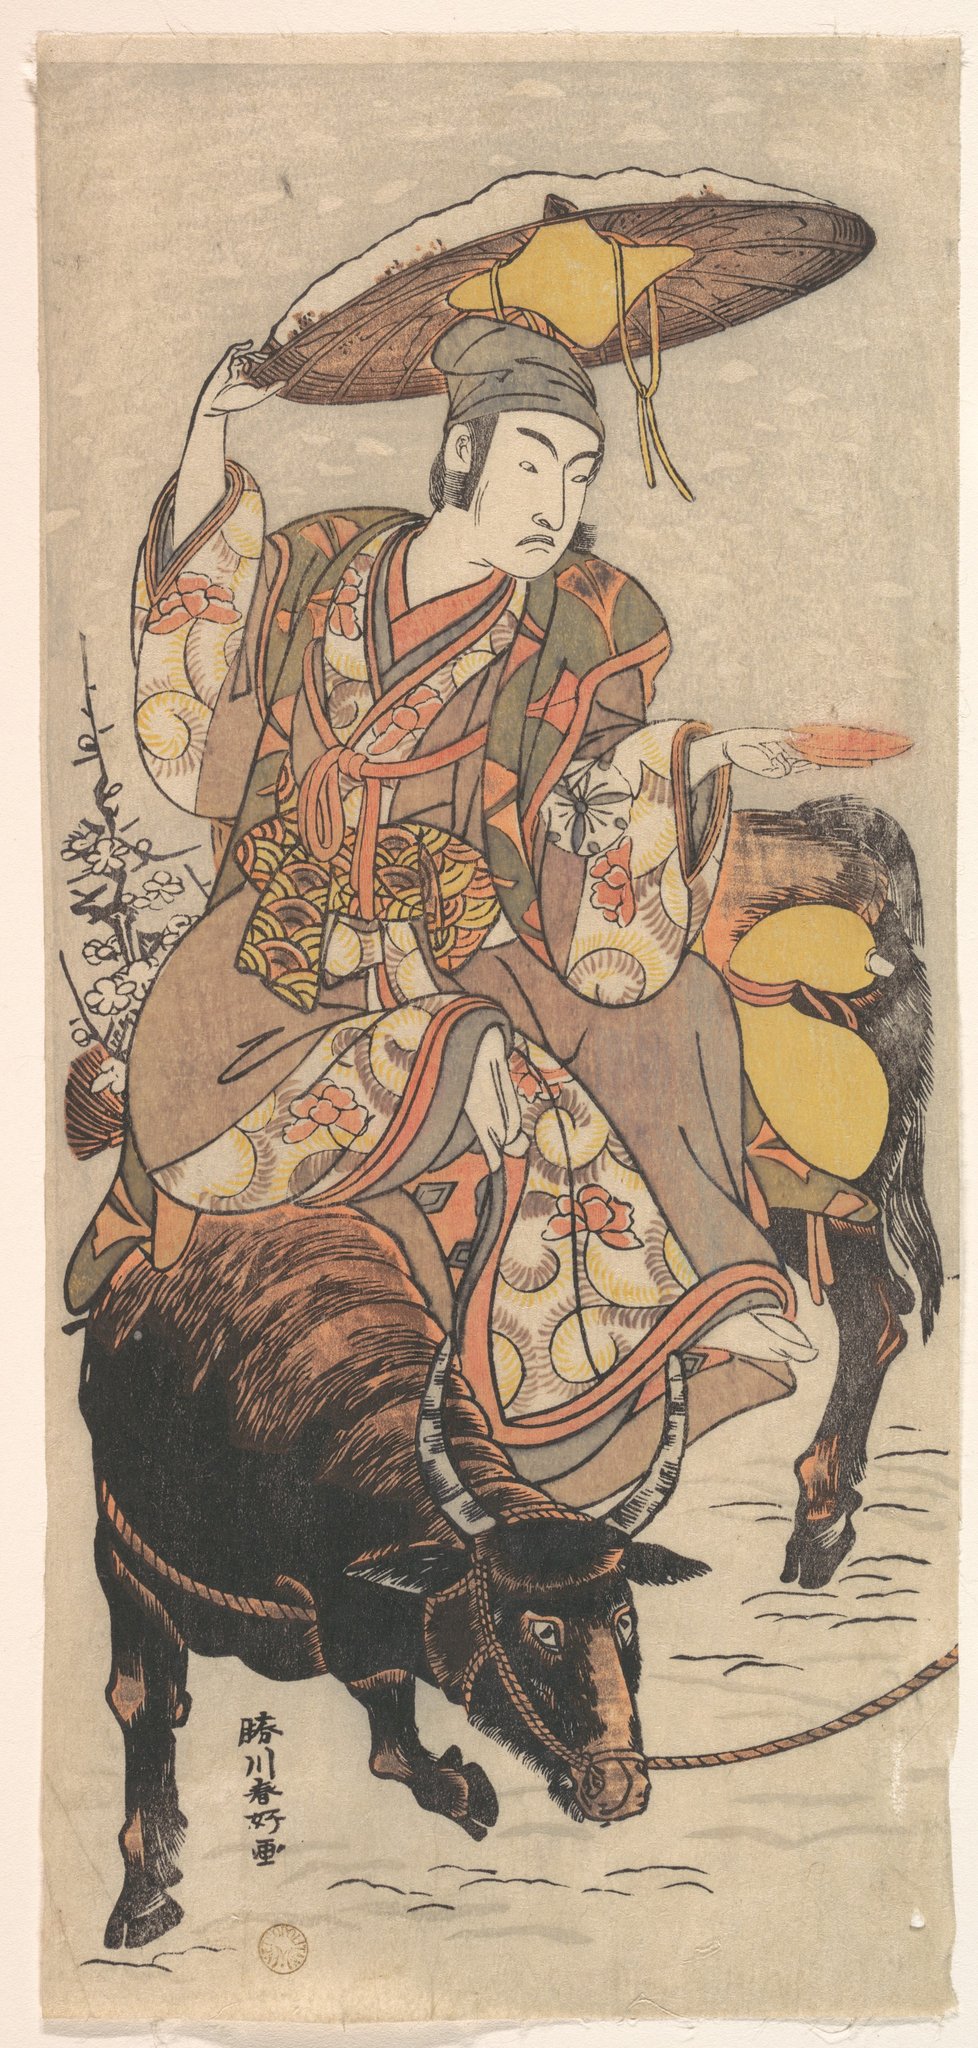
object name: print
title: The Actor Matsumoto Koshiro IV on a Bullock in a Snowstorm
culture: japanese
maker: katsukawa shunkō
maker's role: artist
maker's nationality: japanese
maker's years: 1743-1812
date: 1790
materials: ink, paper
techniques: woodblock print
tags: animals,men,actors